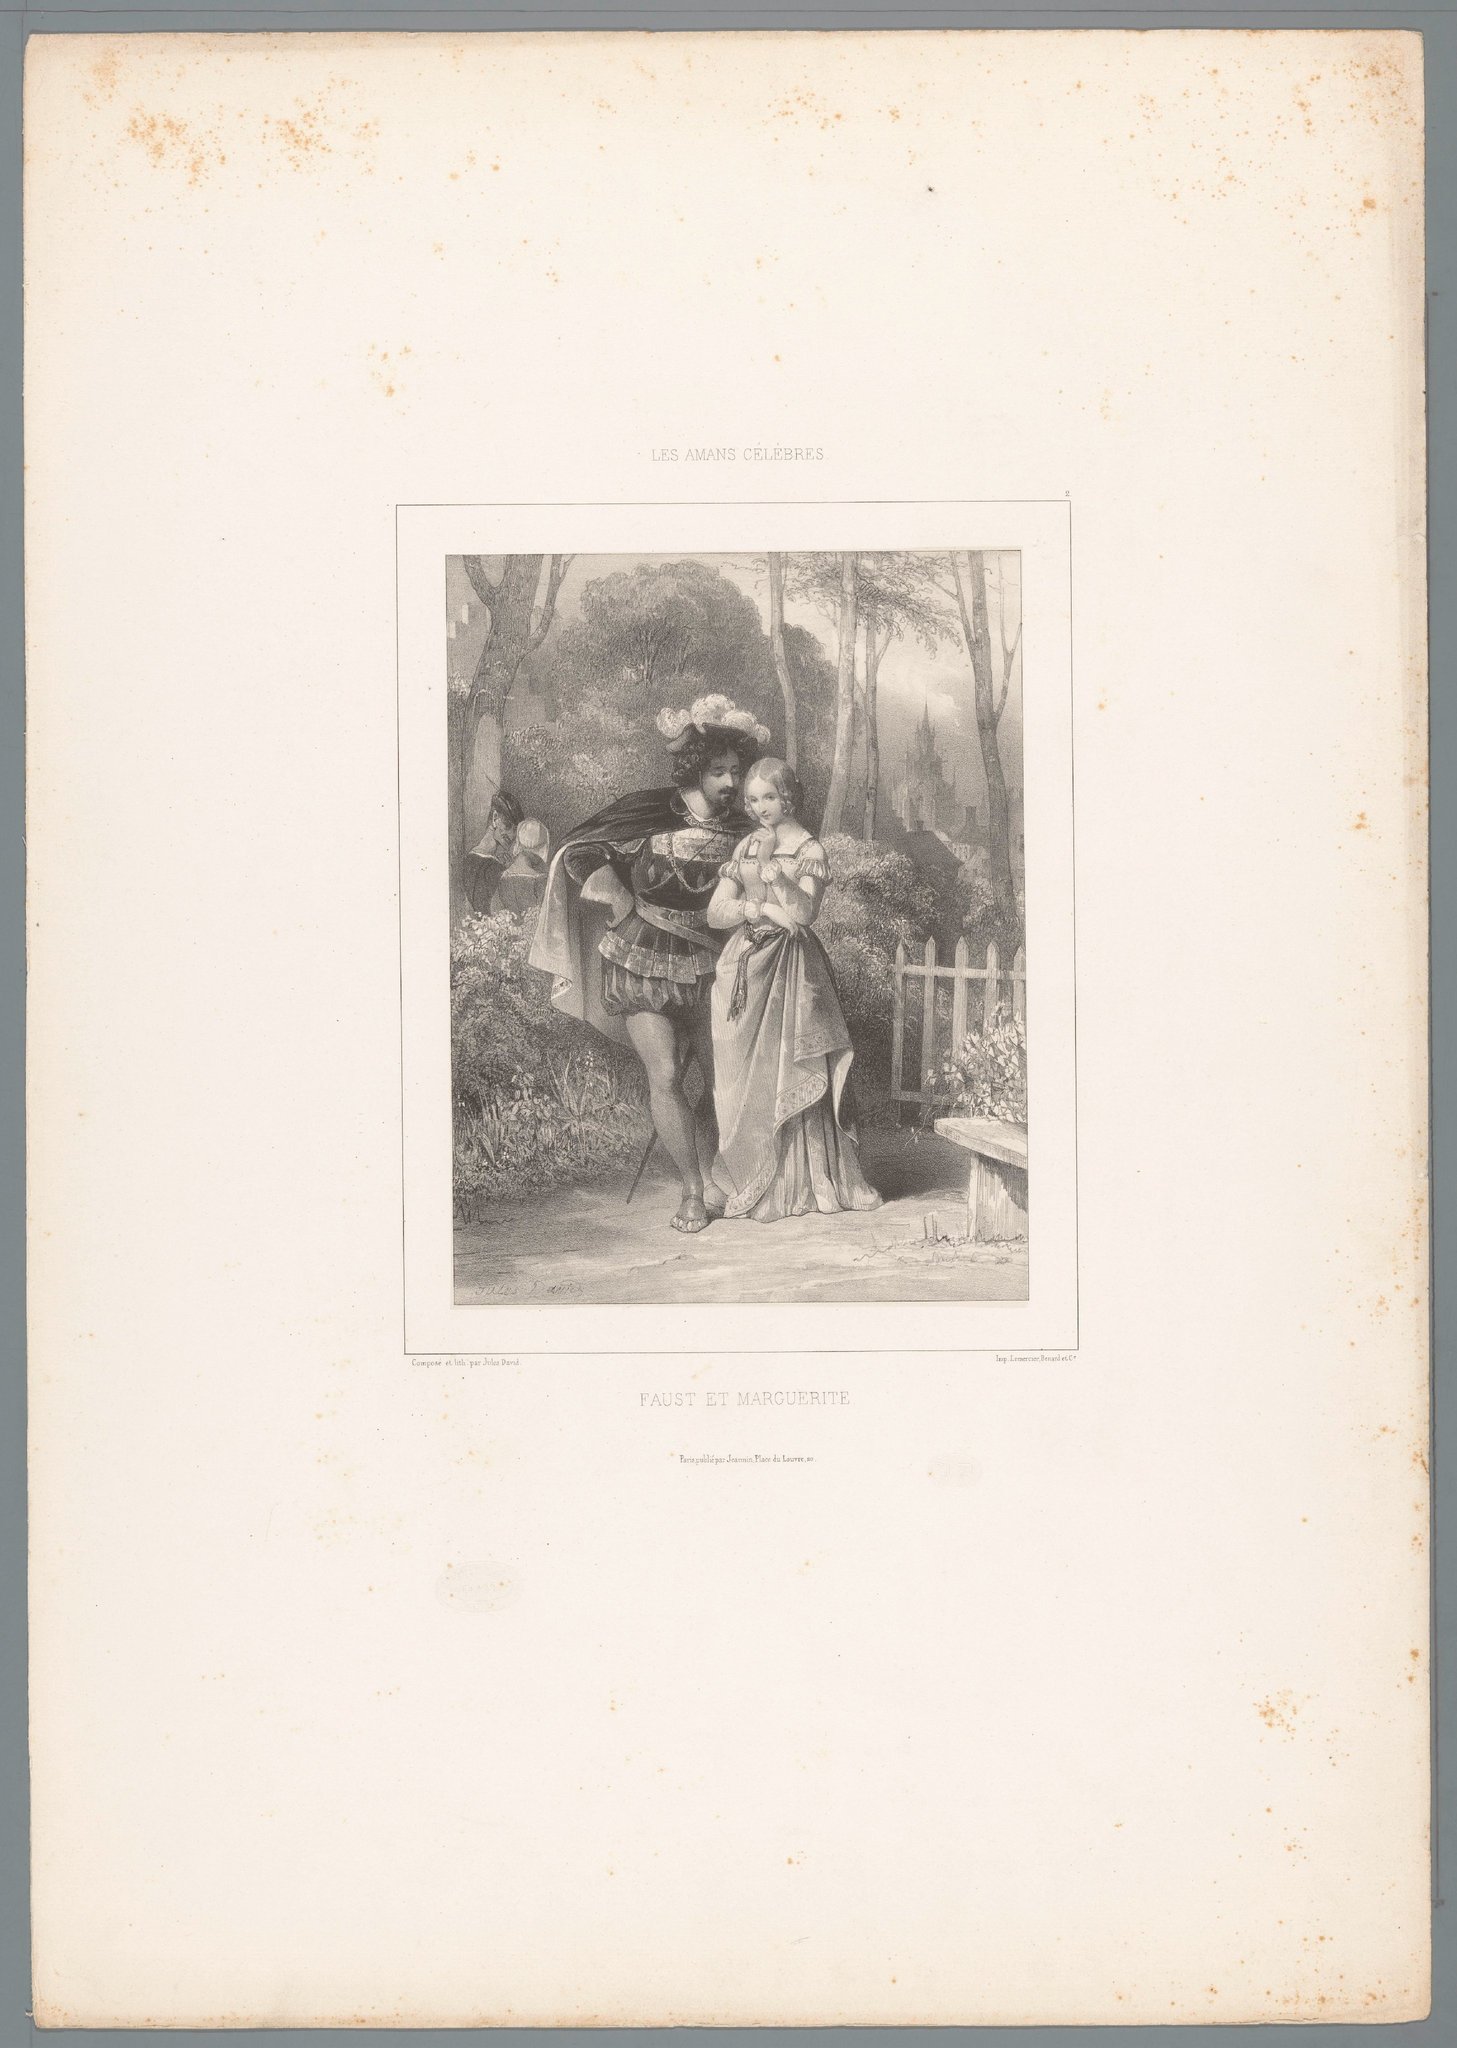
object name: print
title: Faust et Marguerite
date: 1841-1843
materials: paper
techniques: lithograph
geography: paris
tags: faust, couple of lovers, (scenes from) specific works of literature: goethe, faust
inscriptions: check stamp: Lugt 1397c, check stamp: Lugt 3903, collector's mark: Lugt 2228a